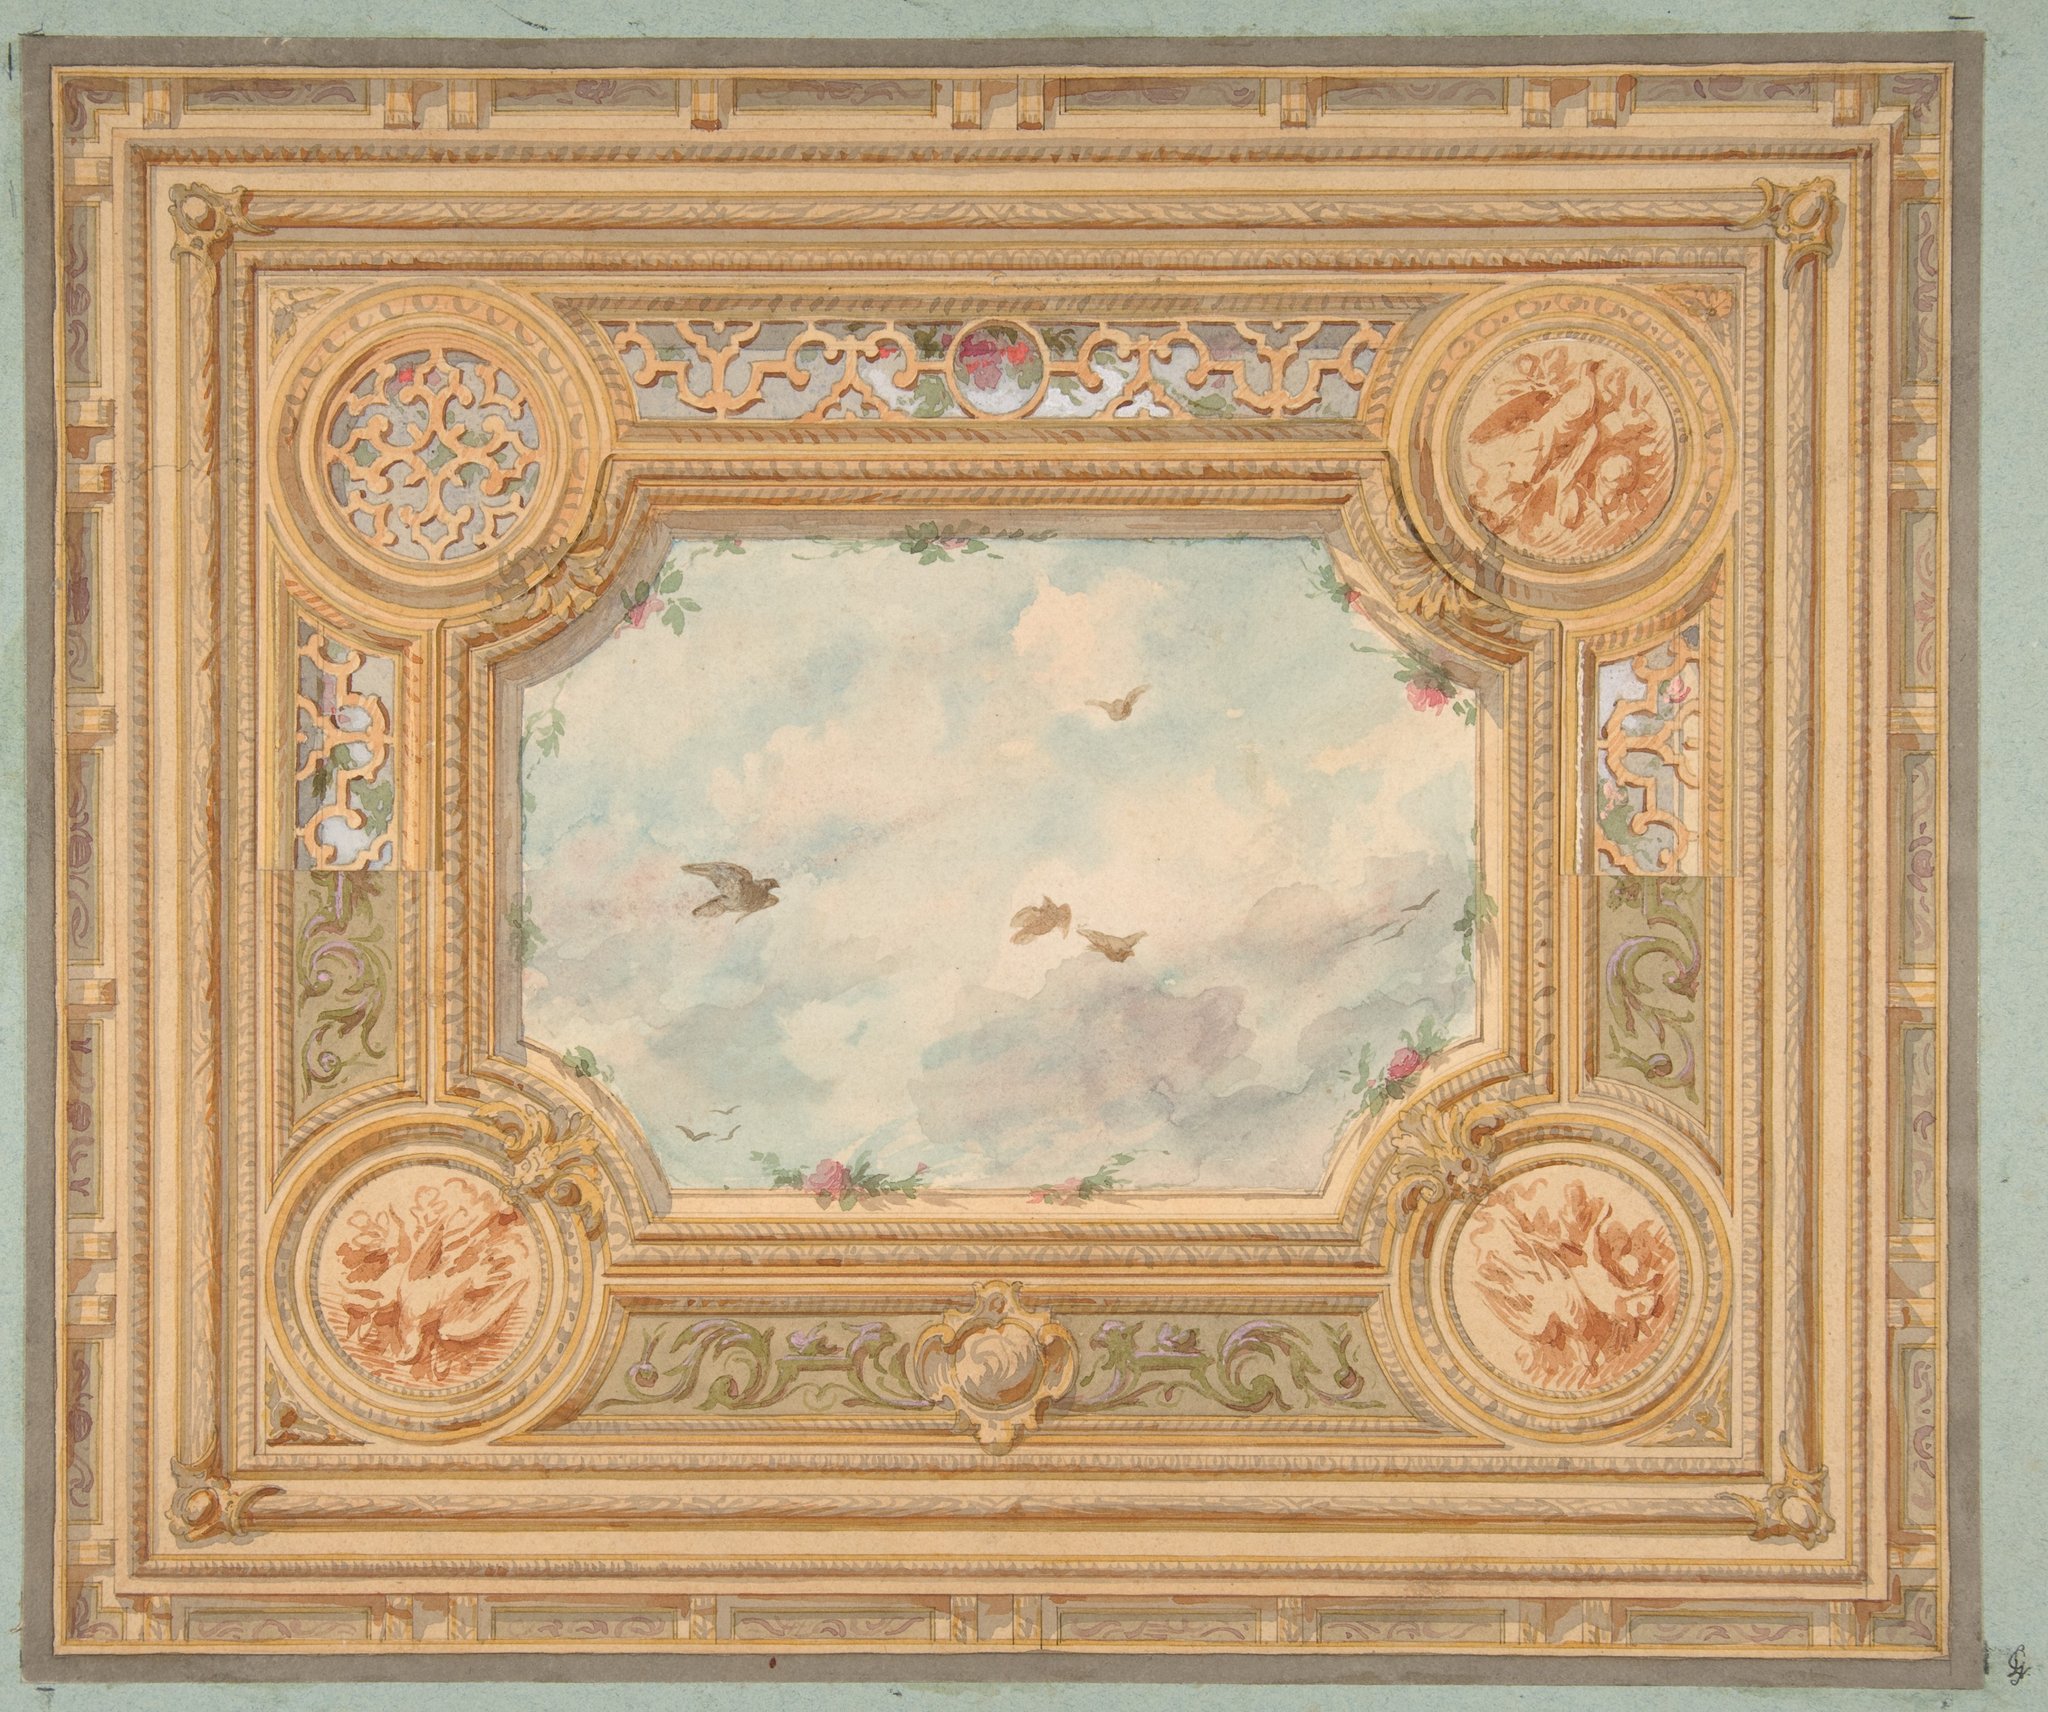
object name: drawing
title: Design for a ceiling with four medallions and sky motif in center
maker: jules-edmond-charles lachaise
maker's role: artist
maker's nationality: french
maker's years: 1897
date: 1851-1900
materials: graphite, watercolor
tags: birds,sky,ceilings